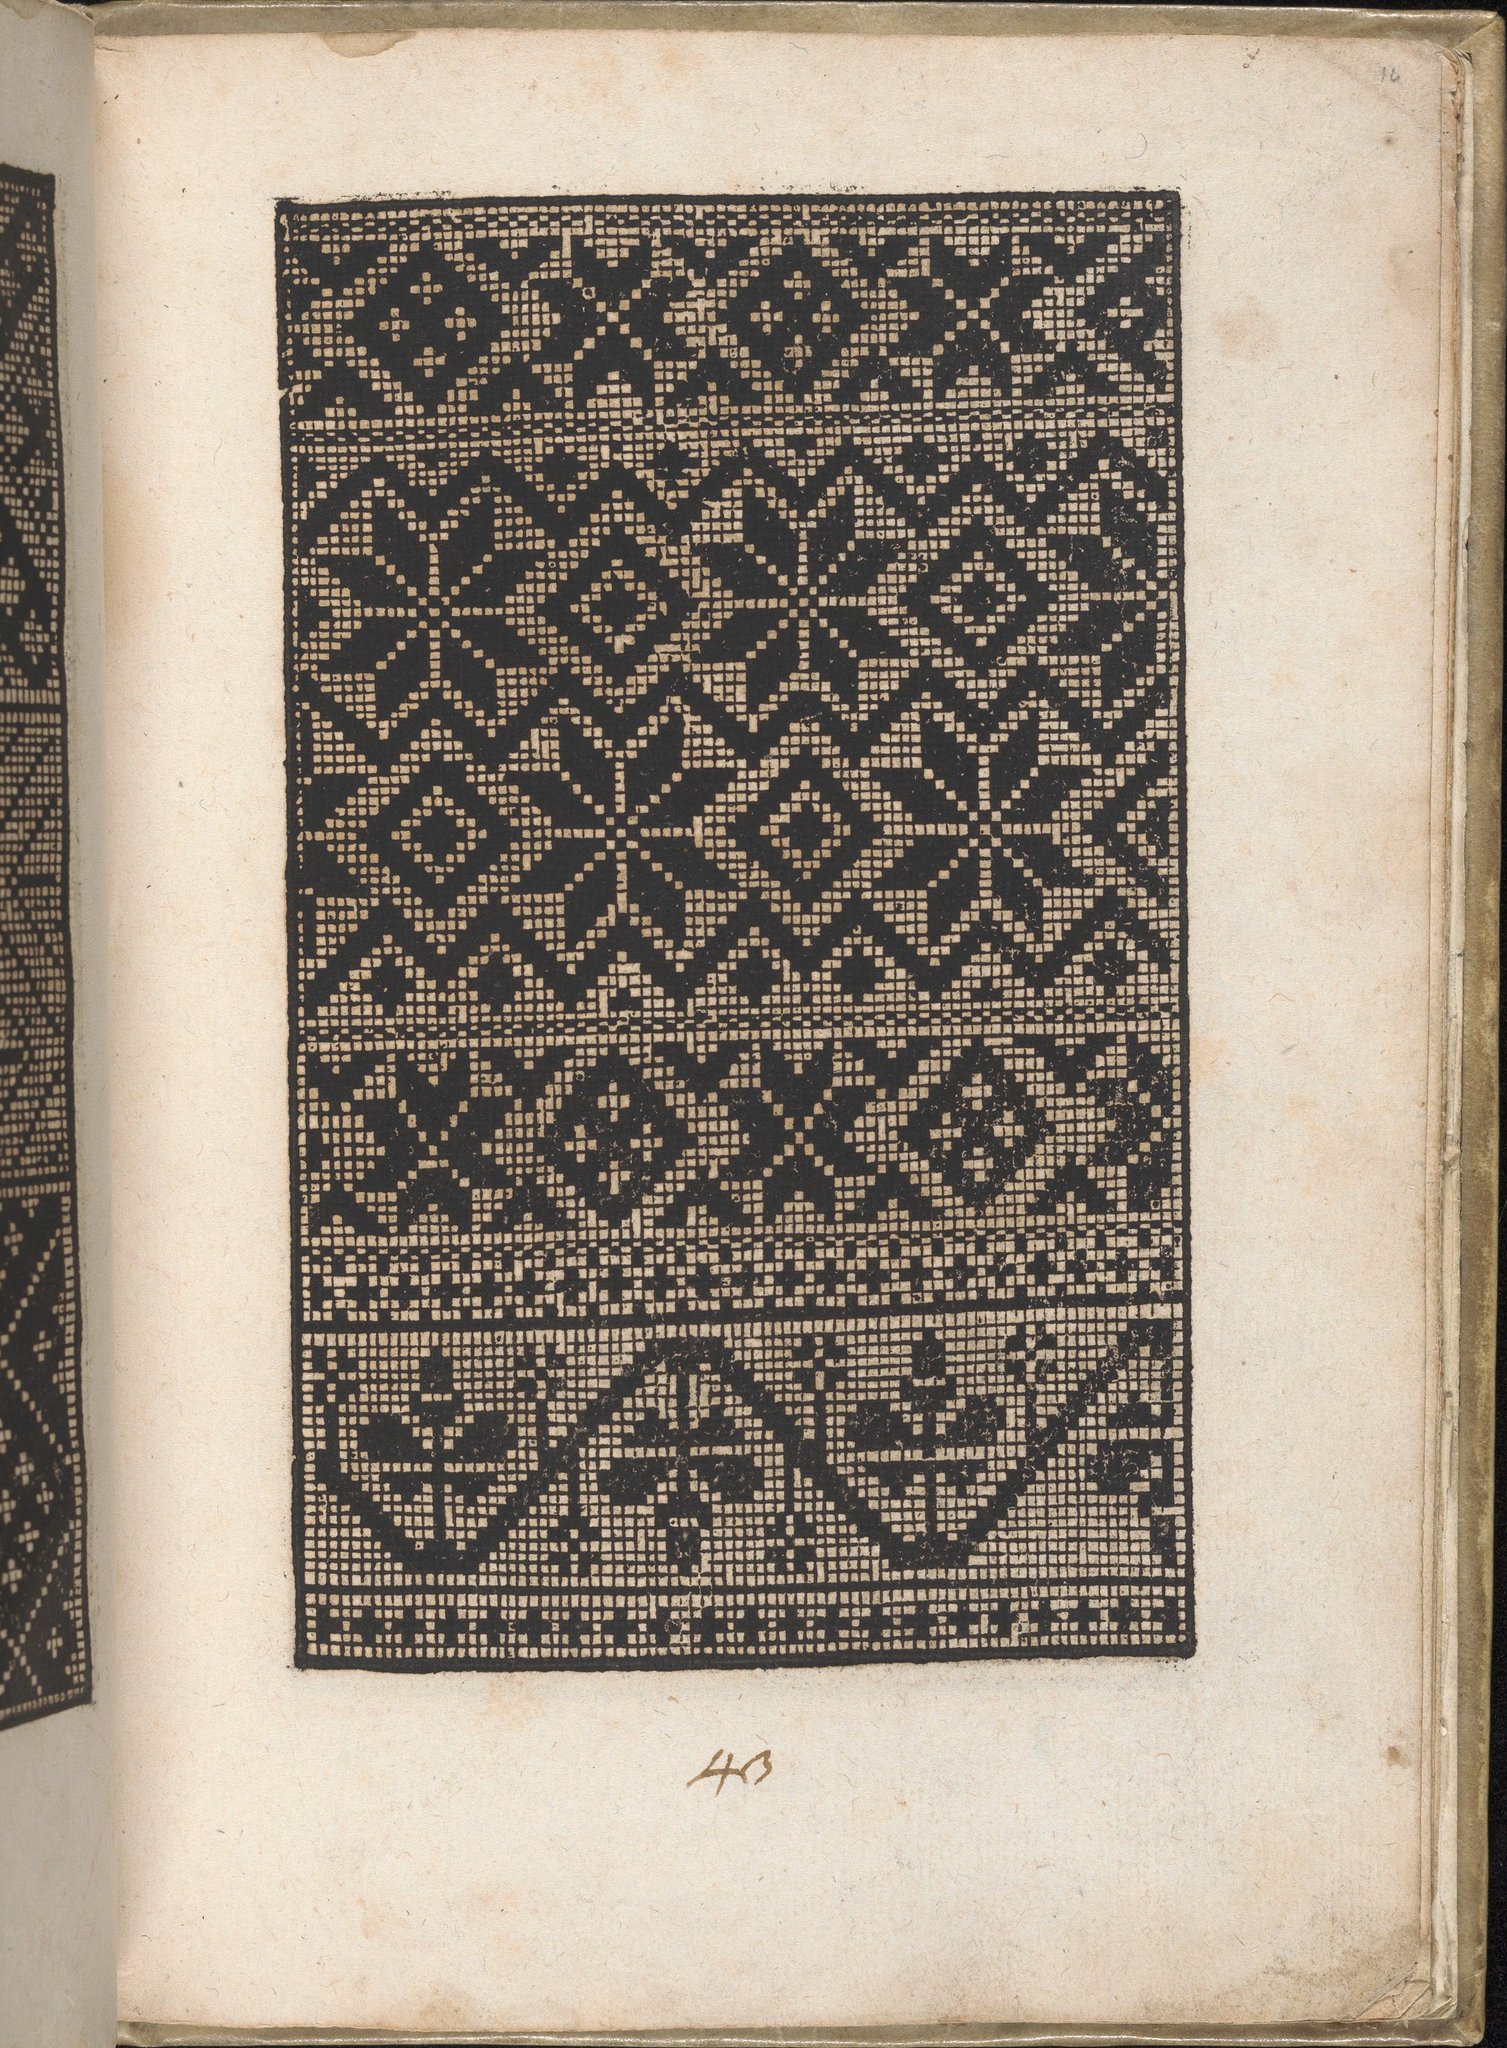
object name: book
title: Page 17r, from "Eyn New Kunstlichboich"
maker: peter quentel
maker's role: publisher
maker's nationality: german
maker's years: 1500-1550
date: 1529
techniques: woodcut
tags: ornament